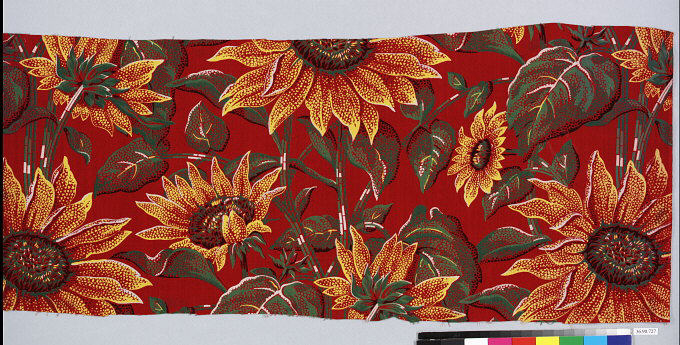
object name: piece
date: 1867-1900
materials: cotton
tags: sunflowers,leaves